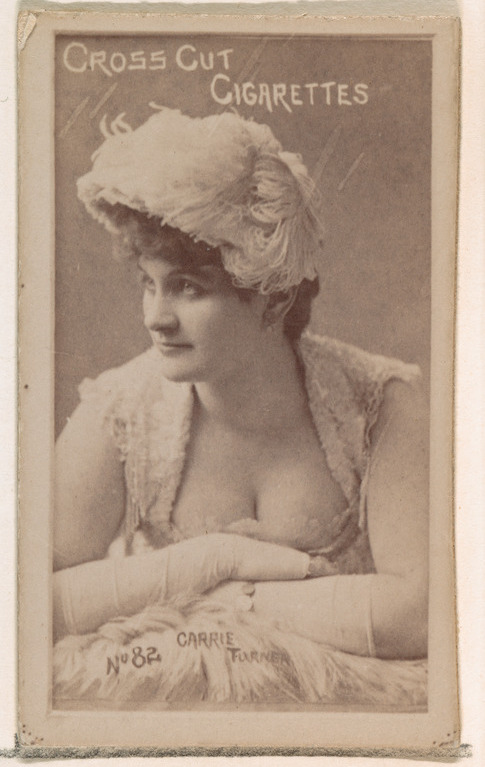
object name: print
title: Card Number 82, Carrie Turner, from the Actors and Actresses series (N145-1) issued by Duke Sons & Co. to promote Cross Cut Cigarettes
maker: w. duke, sons & co.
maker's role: publisher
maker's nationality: american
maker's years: 1870-1920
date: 1880-1889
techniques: albumen silver print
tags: portraits,women,actresses